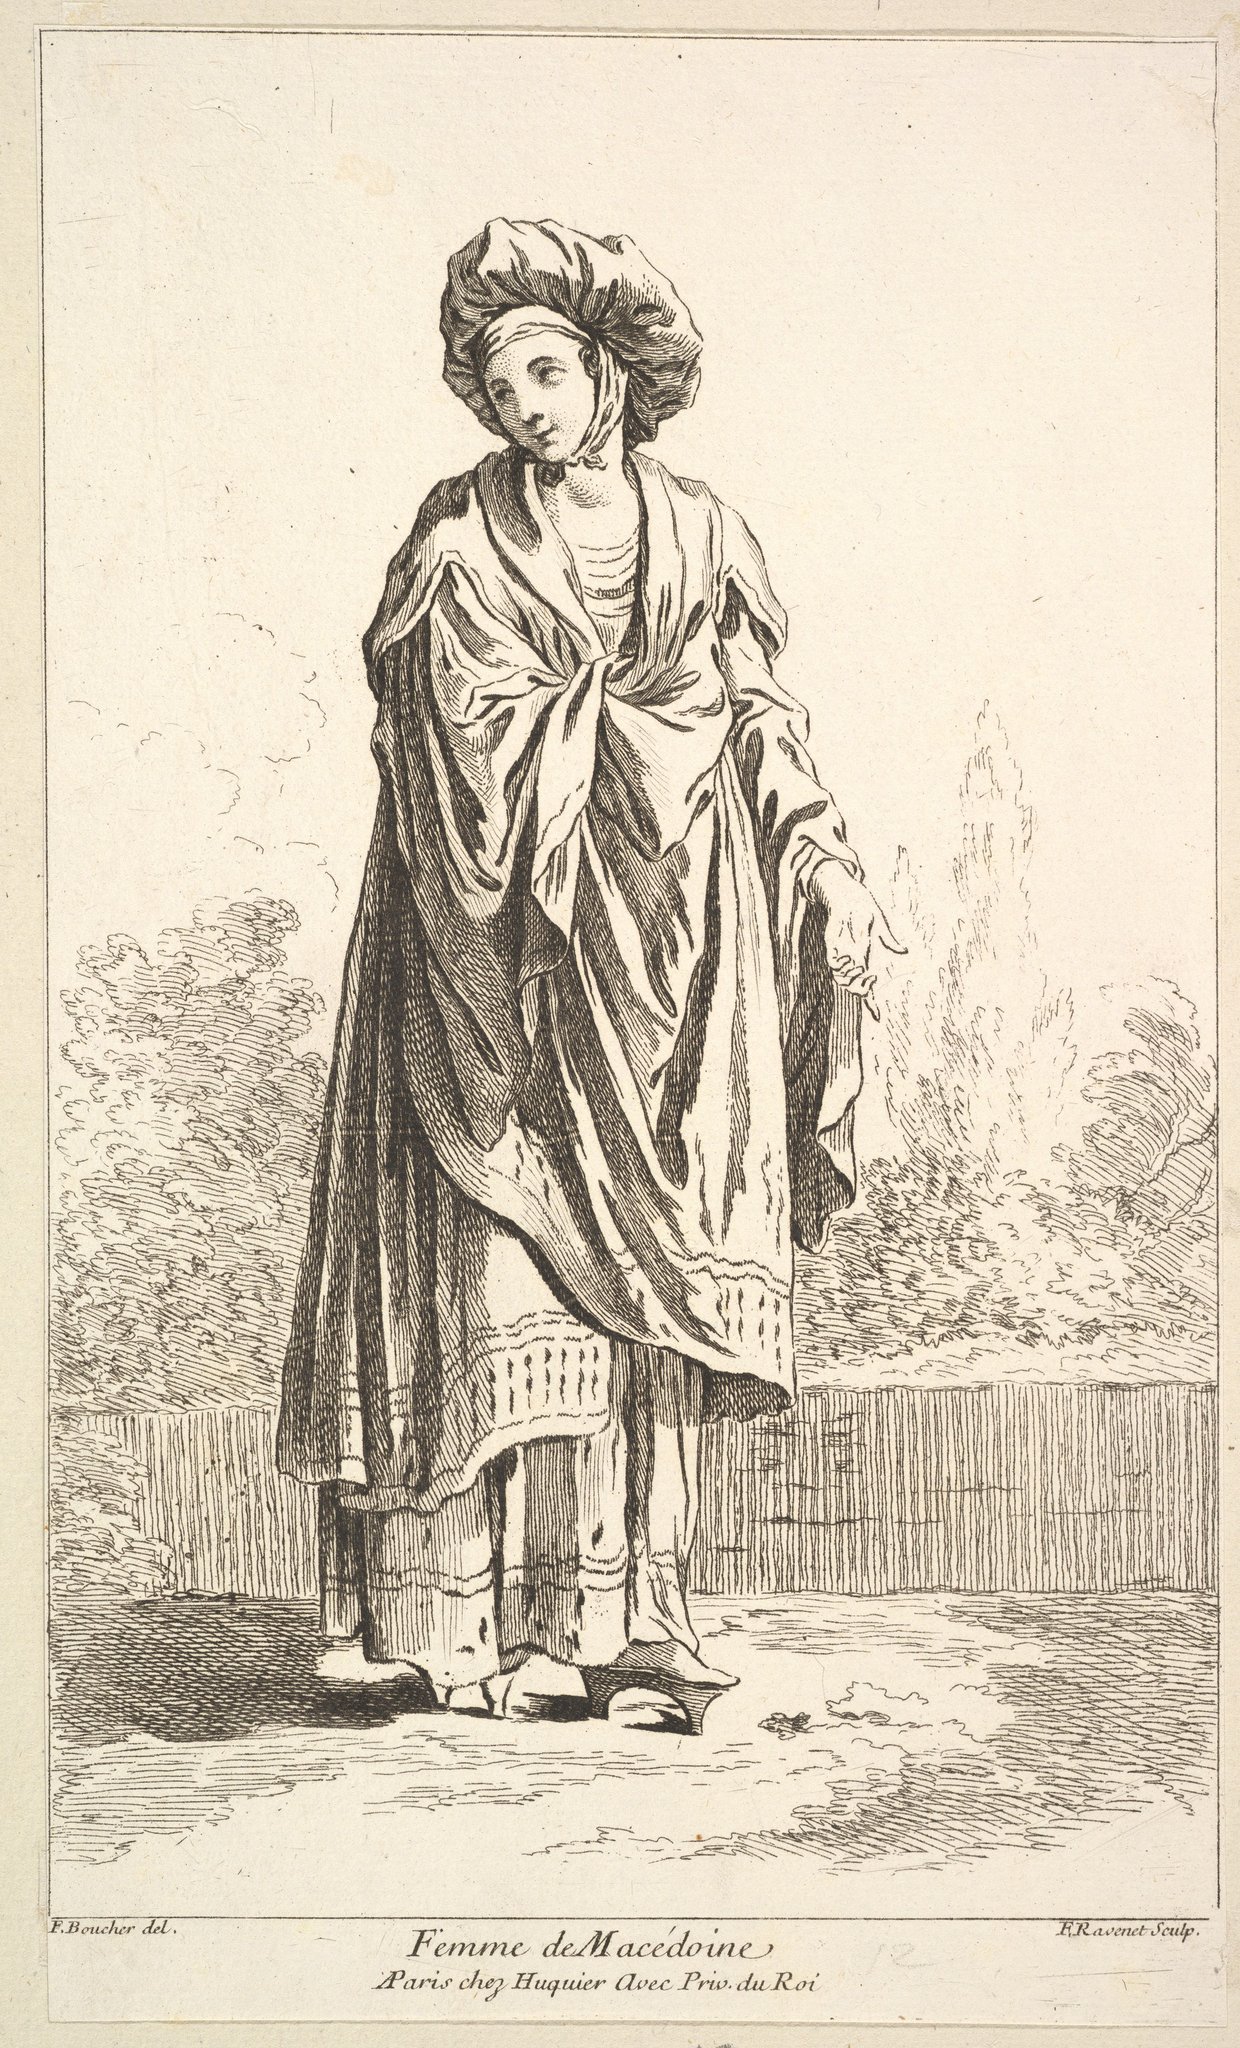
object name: print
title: Femme de Macédoine, plate 12 from "Recueil de diverses fig.res étrangeres Inventées par F. Boucher P.tre du Roy et Gravées par F. Ravenet" (Collection of Various Foreign Figures, Devised by F. Boucher, Painter of the King and Engraved [etched] by F. Ravenet)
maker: simon francis ravenet, the elder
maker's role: artist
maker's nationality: french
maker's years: 1706-1774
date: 1701-1800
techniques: engraving, etching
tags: portraits,women